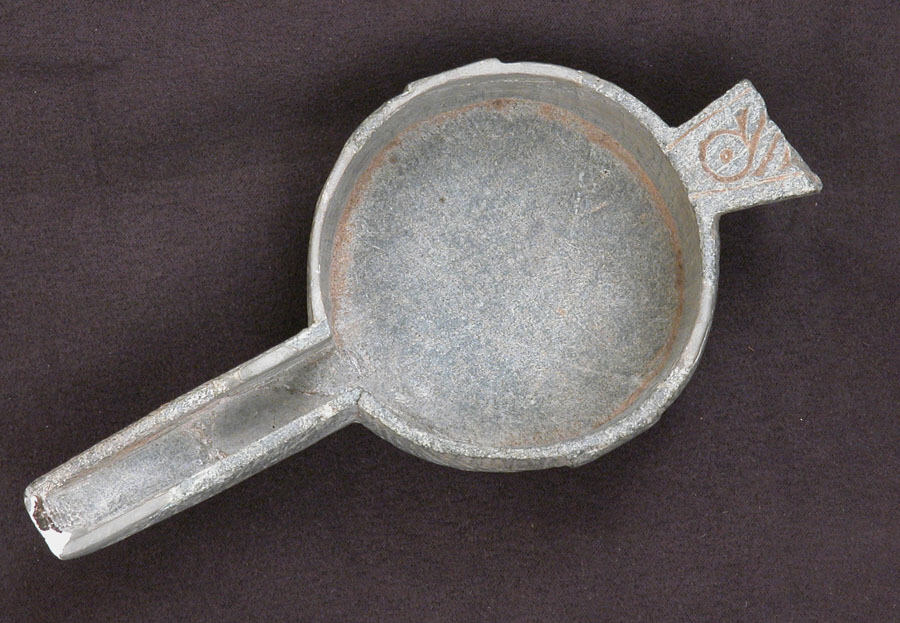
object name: lamp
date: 901-1000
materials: stone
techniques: incising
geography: iran